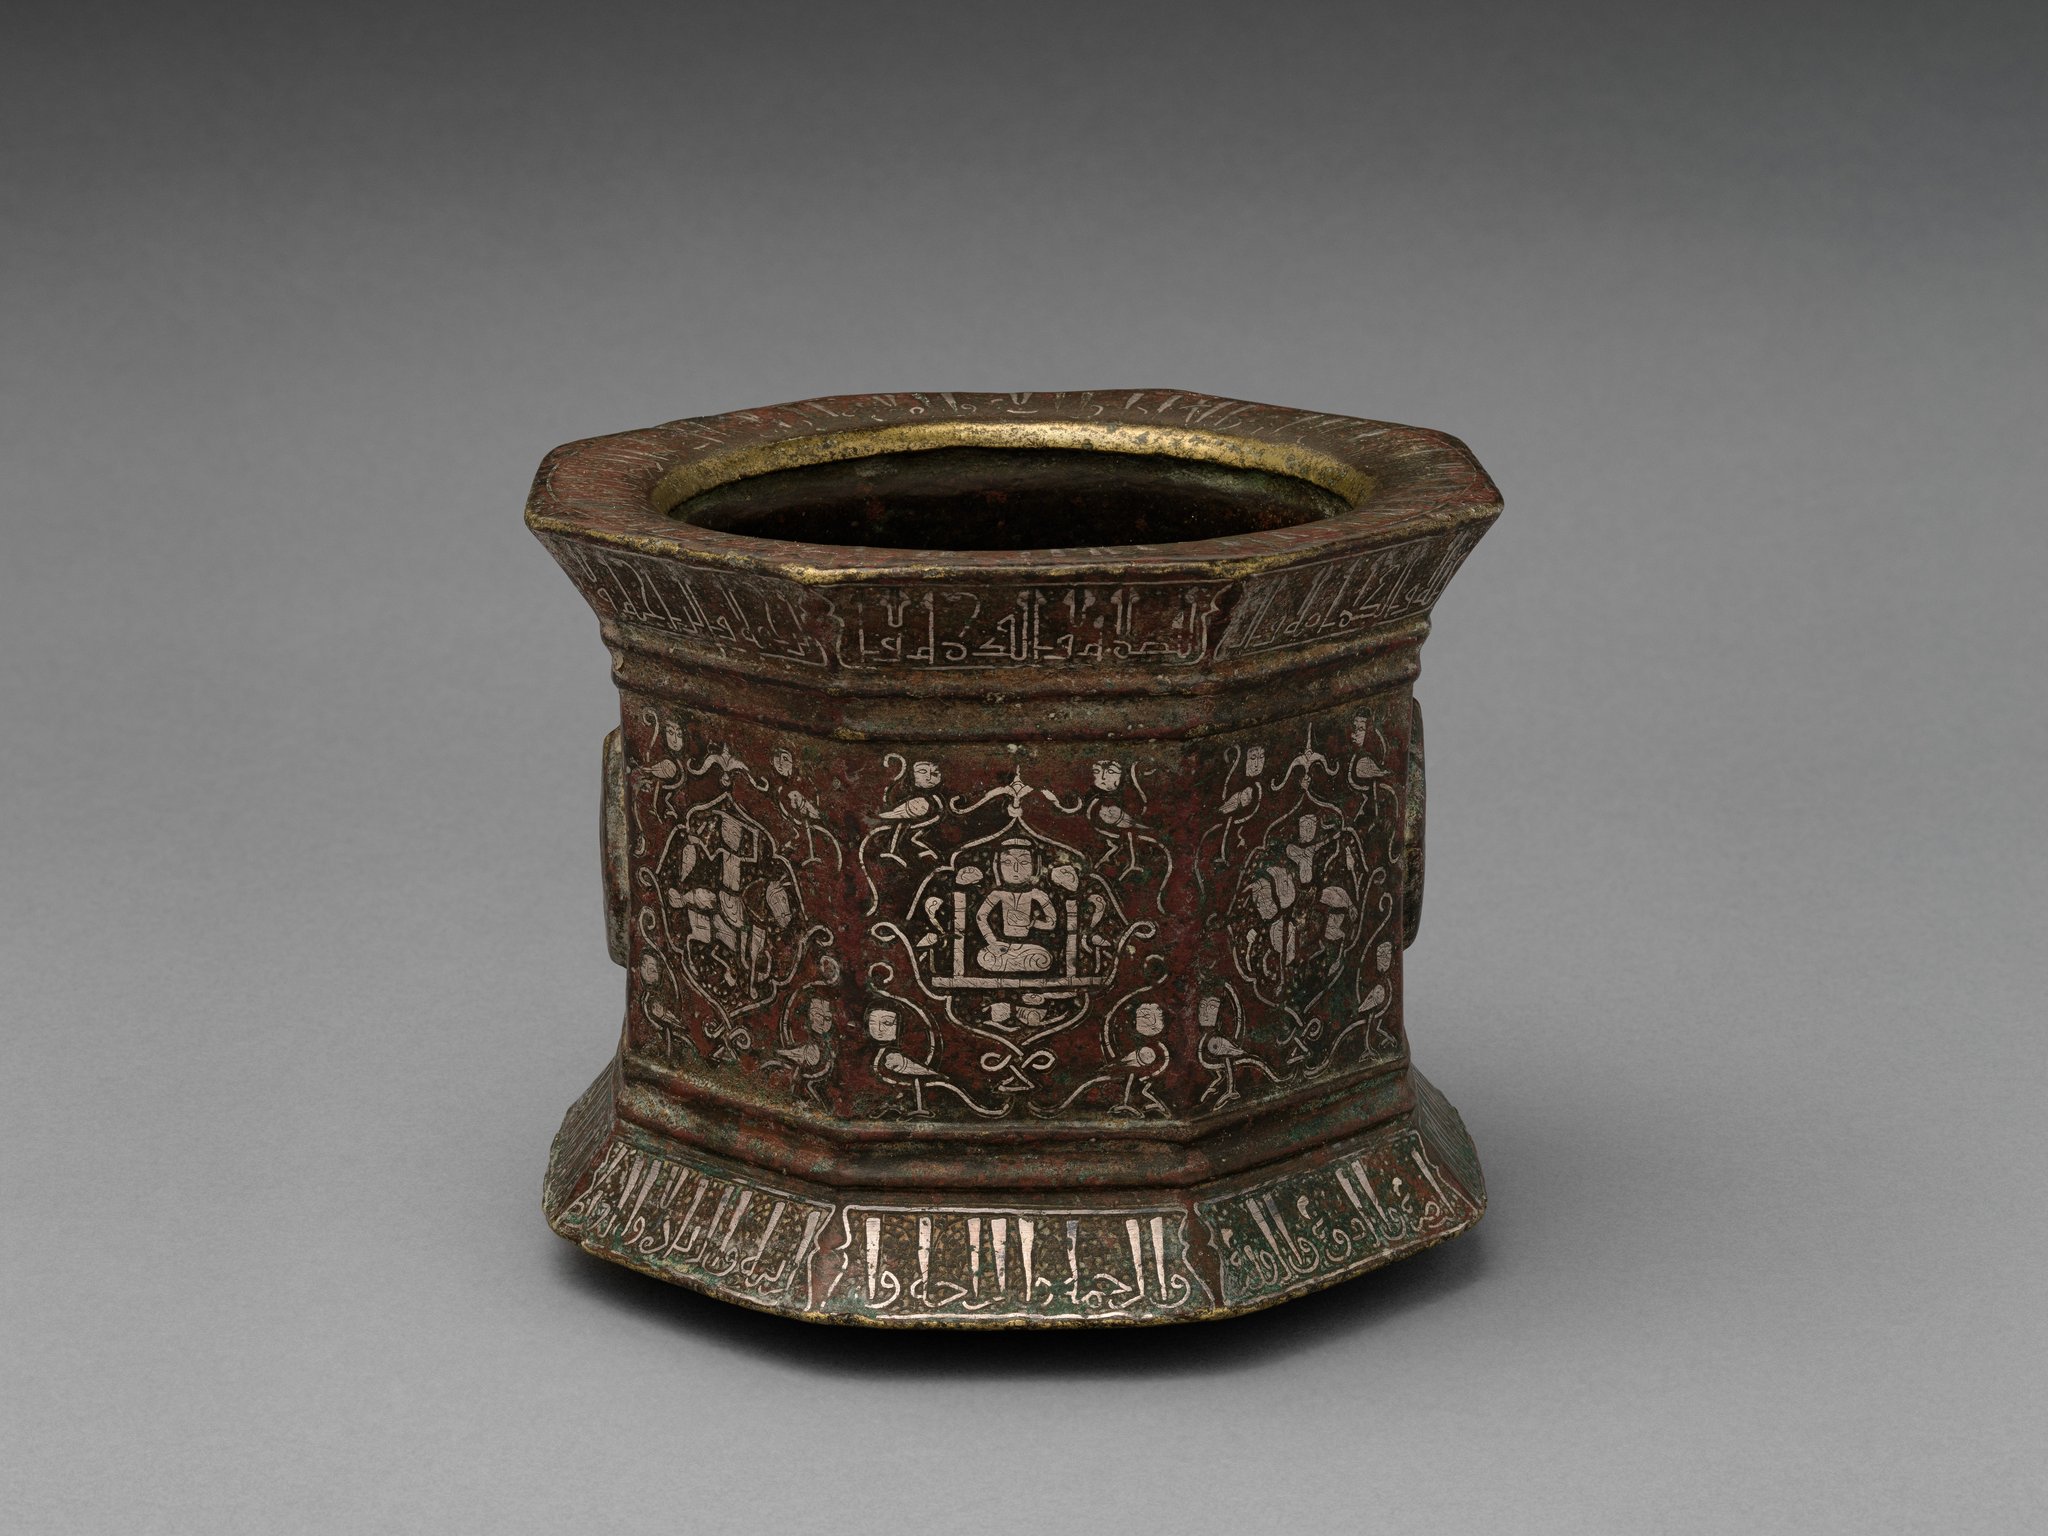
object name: mortar and pestle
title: Mortar and Pestle made for Abu Bakr 'Ali Malikzad al-Tabrizi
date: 1167-1233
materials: bronze, silver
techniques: inlay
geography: iran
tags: arabic,mythical creatures